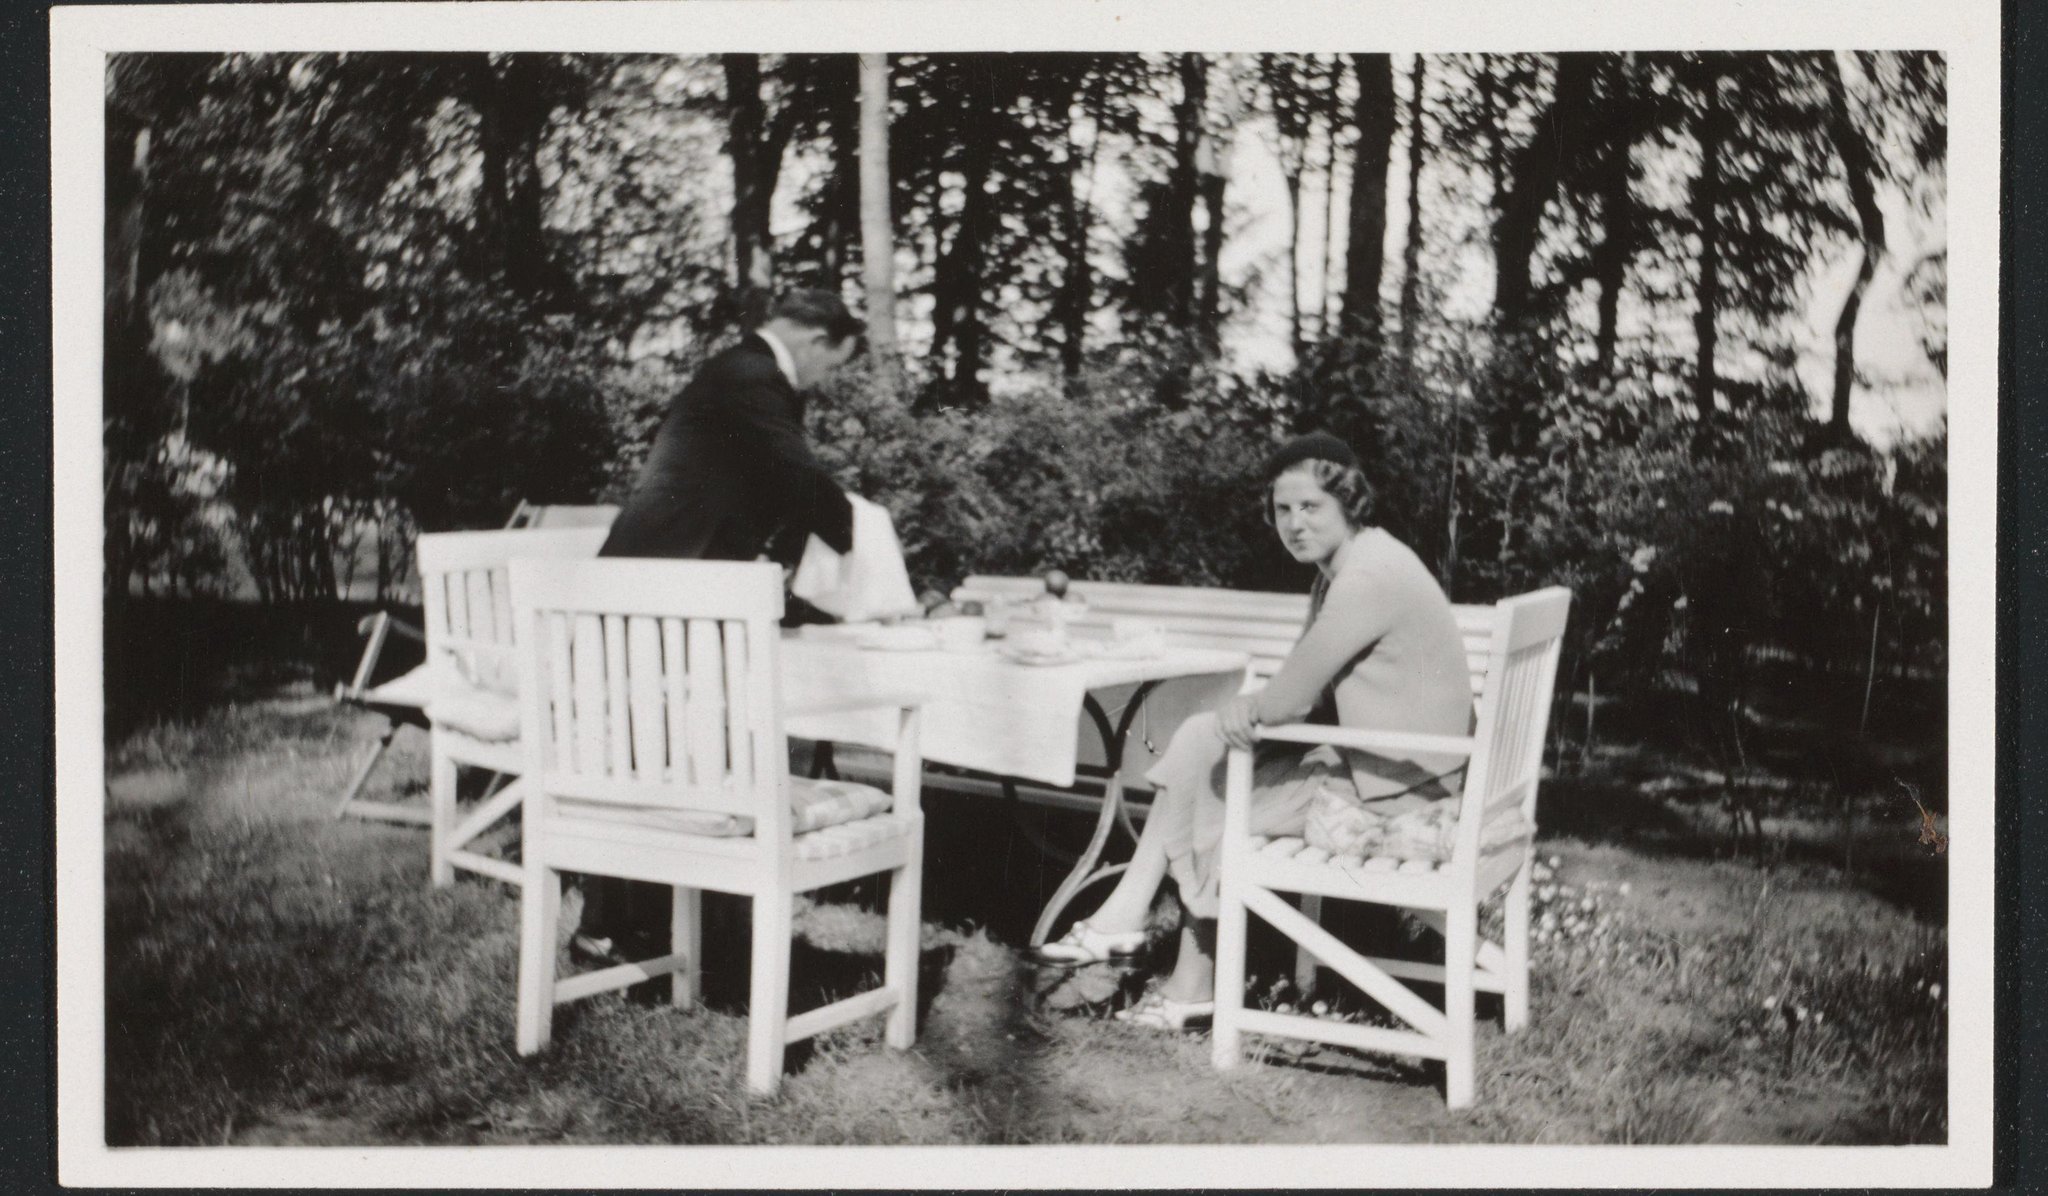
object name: photograph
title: G.A. Brusse-Urtebise aan tafel in een tuin met een serverende ober in Luxemburg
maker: Anonymous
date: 1932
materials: photographic support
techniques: gelatin silver print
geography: luxembourg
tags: garden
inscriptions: inscription: ‘1932 voyage Noe[...] Luxemb.’